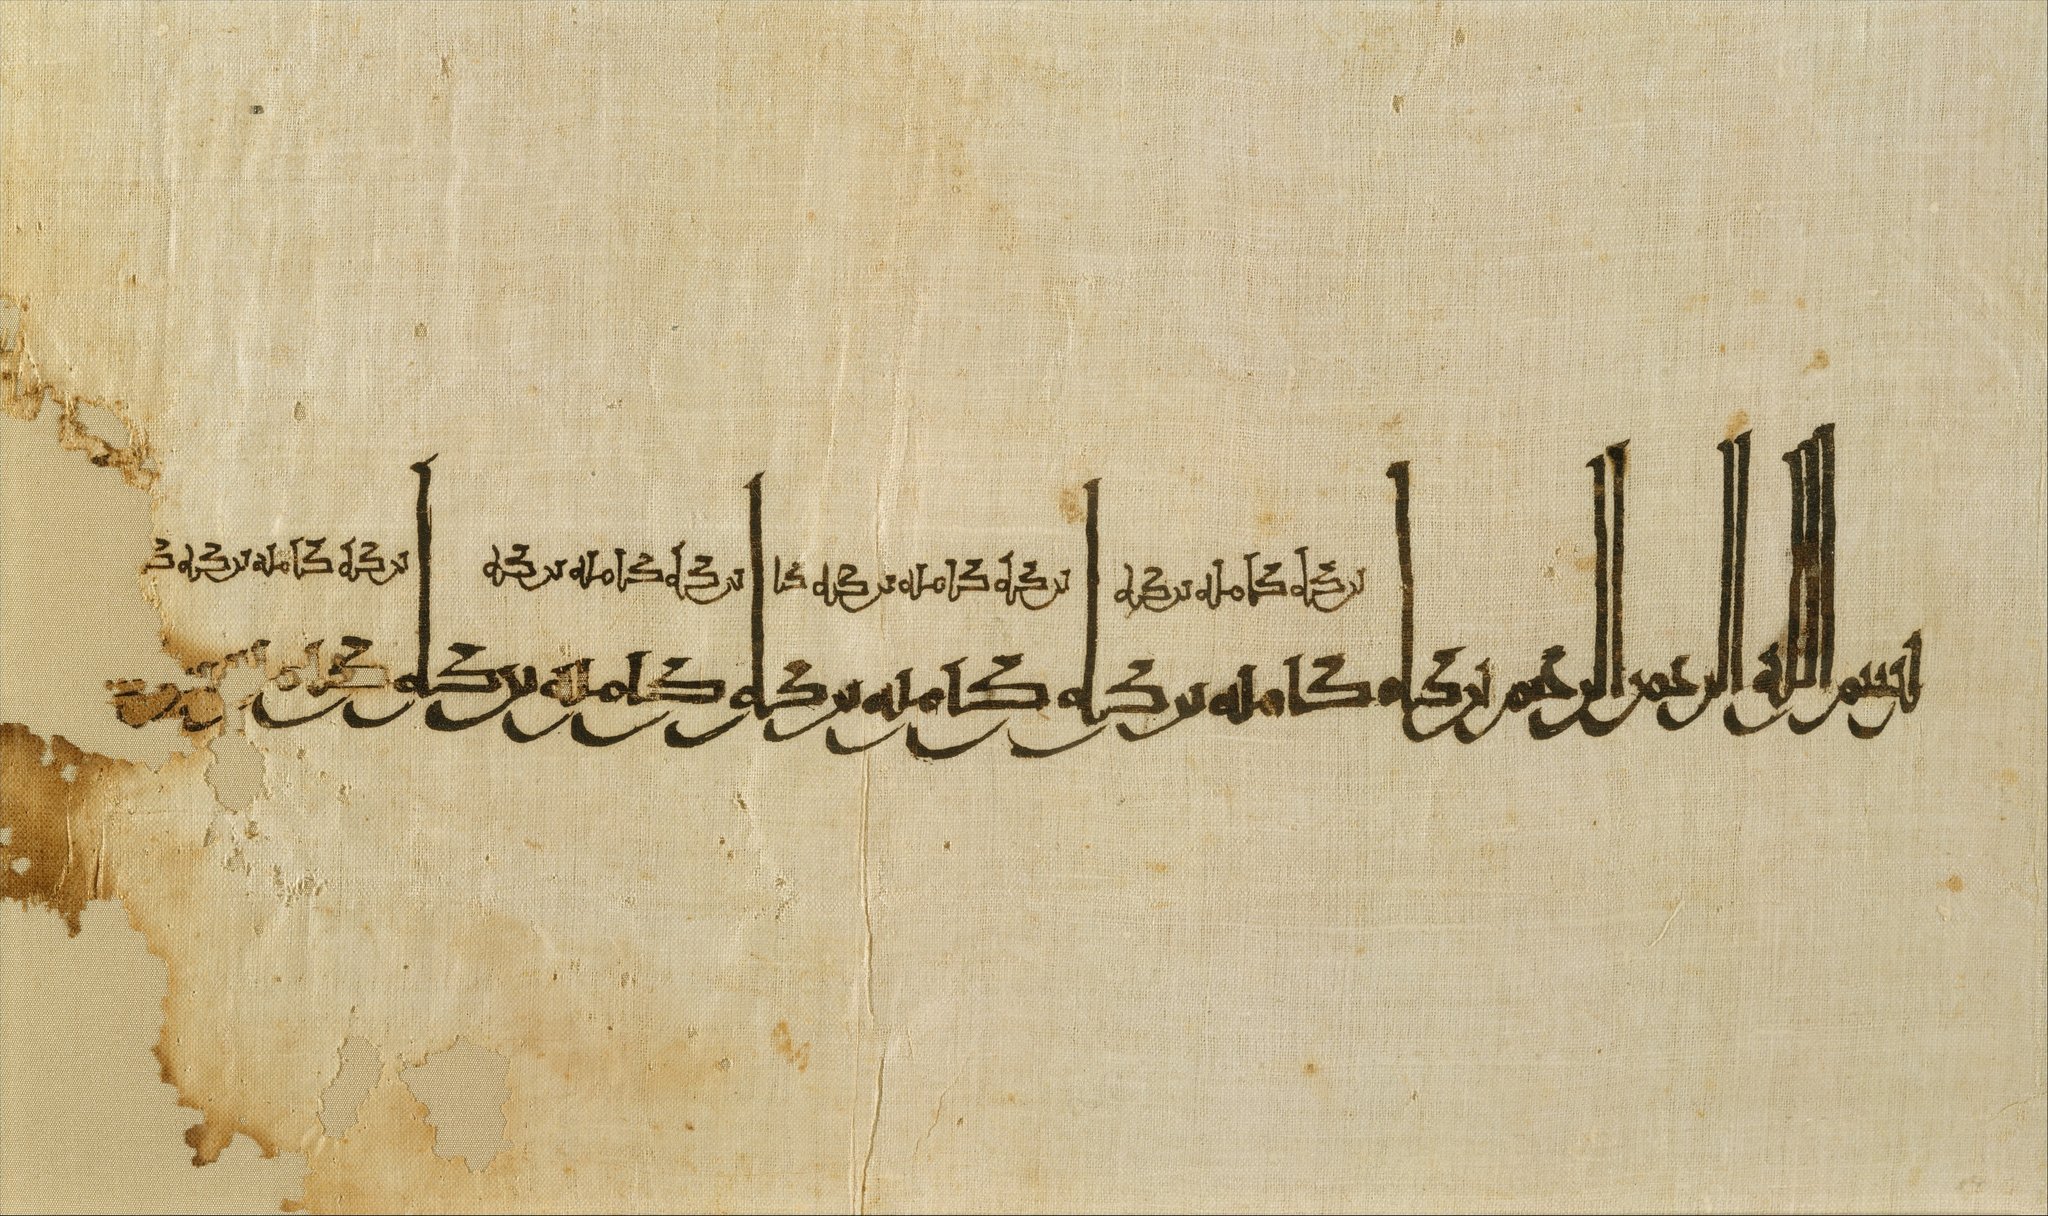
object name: textile fragment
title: <Tiraz> Textile Fragment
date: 967-1000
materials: cotton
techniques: painting, weave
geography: iraq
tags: arabic